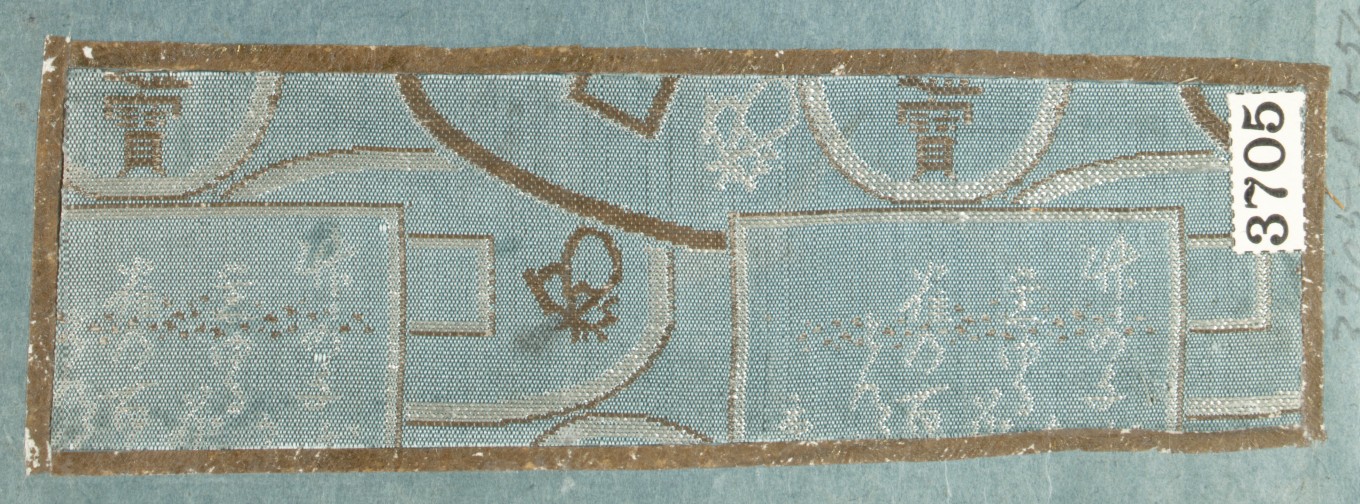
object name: sample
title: Textile Sample from Sample Book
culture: japanese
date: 1801-1900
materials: silk